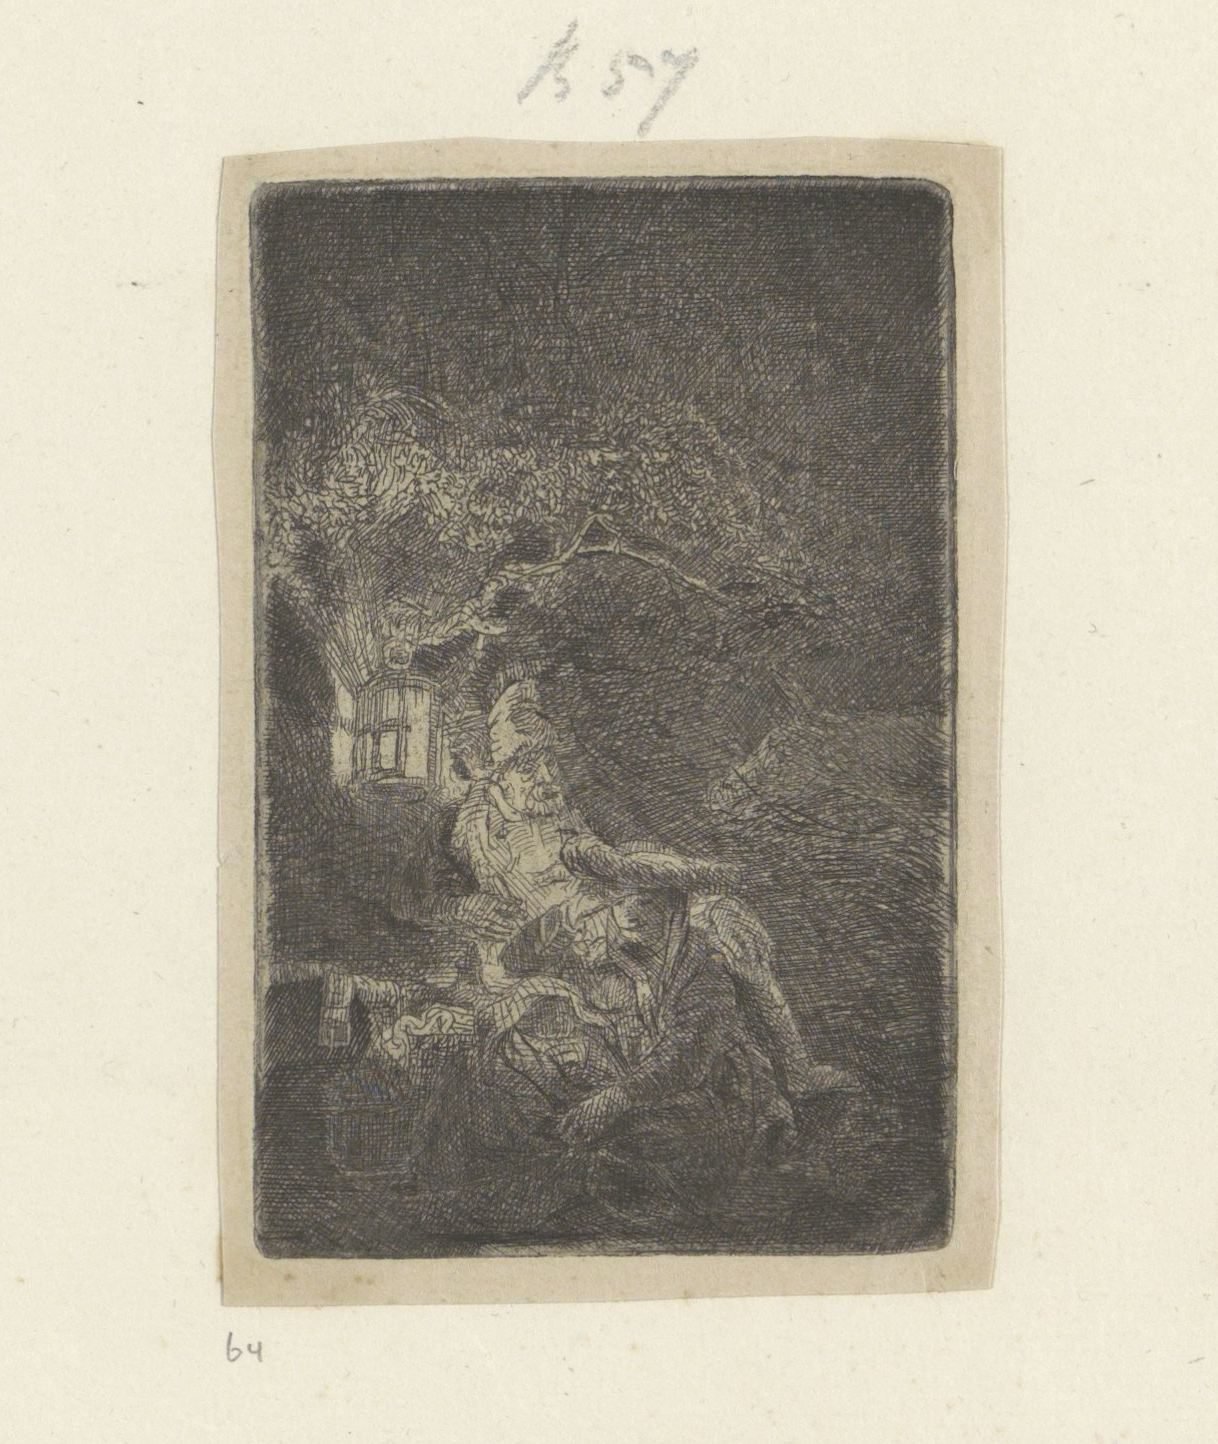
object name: album leaf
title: Rest on the Flight into Egypt at Night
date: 1642-1646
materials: paper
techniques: drypoint, etching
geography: paris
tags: rest on the flight into egypt